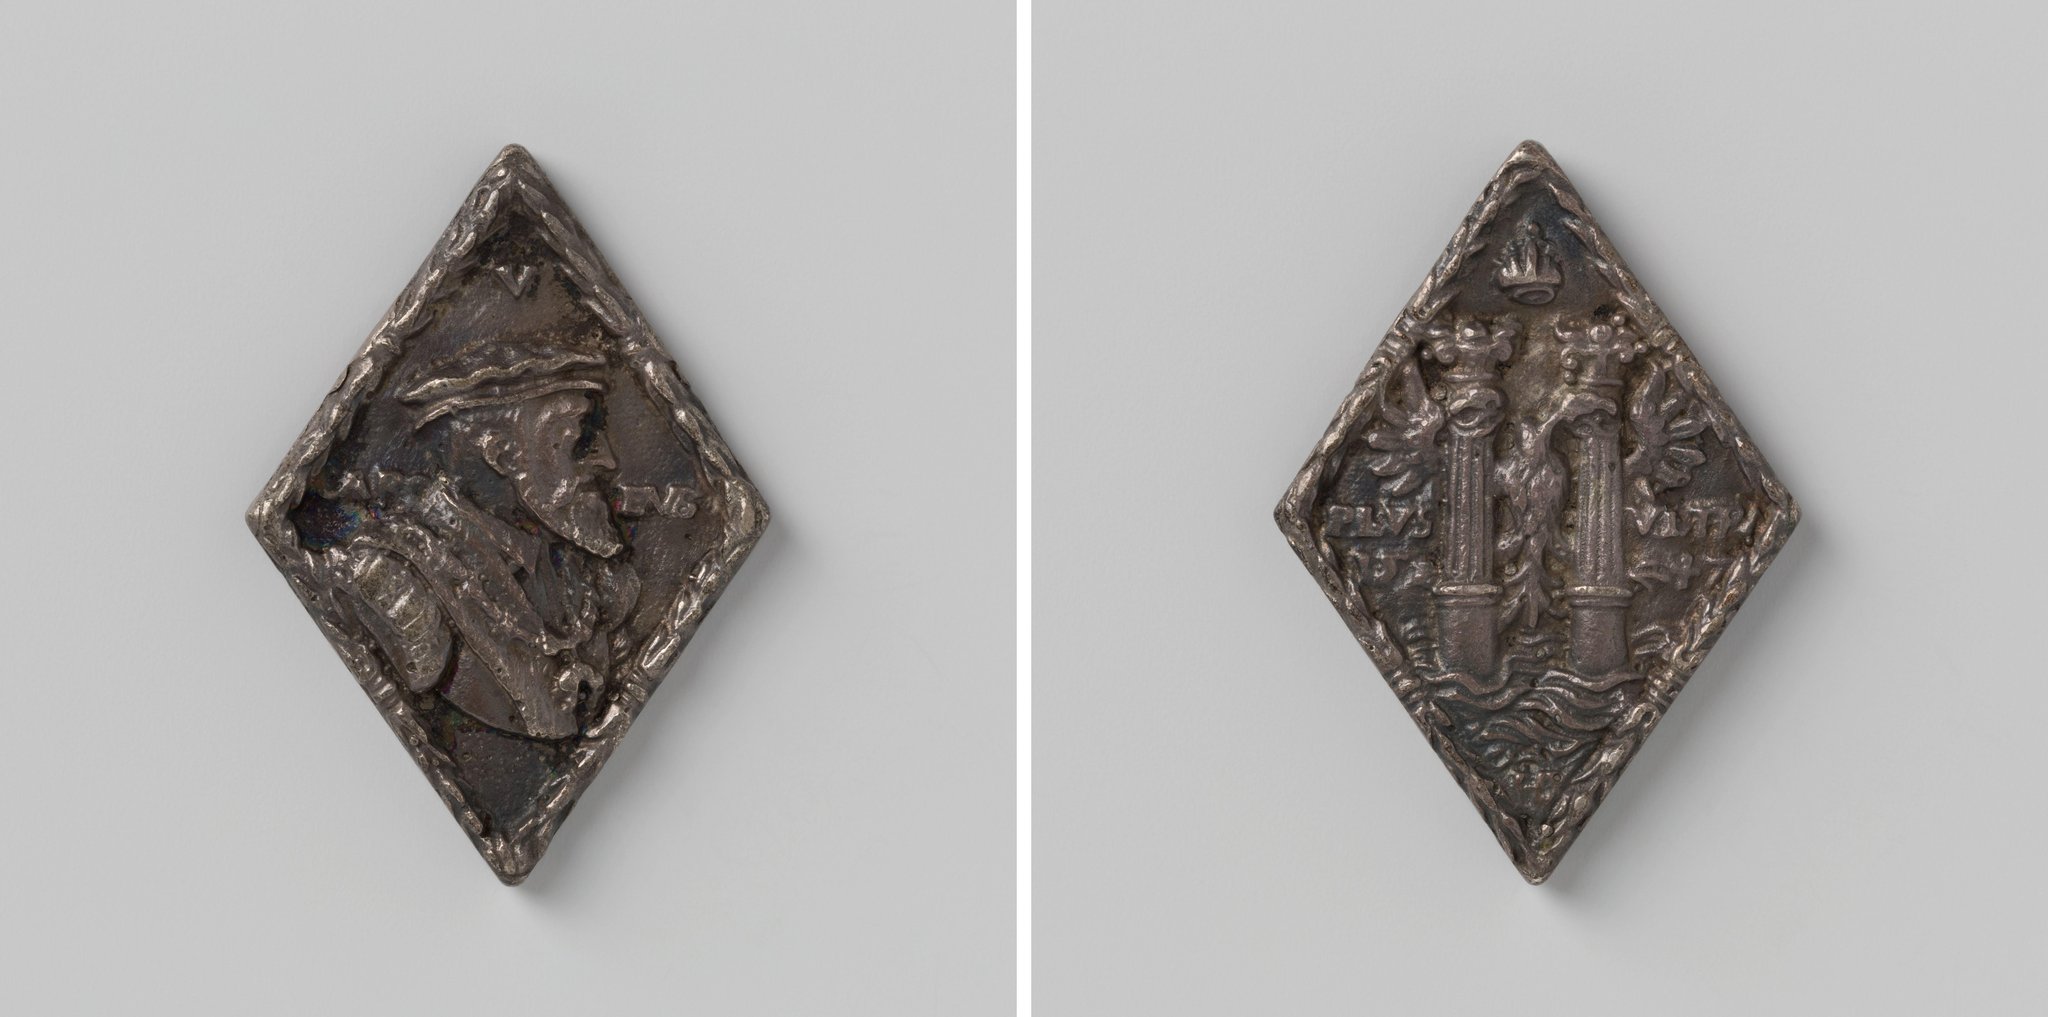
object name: history medal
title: Karel V, Duits keizer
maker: hans reinhart (der ältere)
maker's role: medailleur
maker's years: 1510-1581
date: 1547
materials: silver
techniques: casting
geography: leipzig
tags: ghent, charles v (holy roman emperor and king of spain)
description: ruitvormig; Zilveren penning. Voorzijde: borststuk man binnen sierrand. Keerzijde: tweekoppige adelaar tussen zuilen van Herkules tussen opschrift binnen sierrand